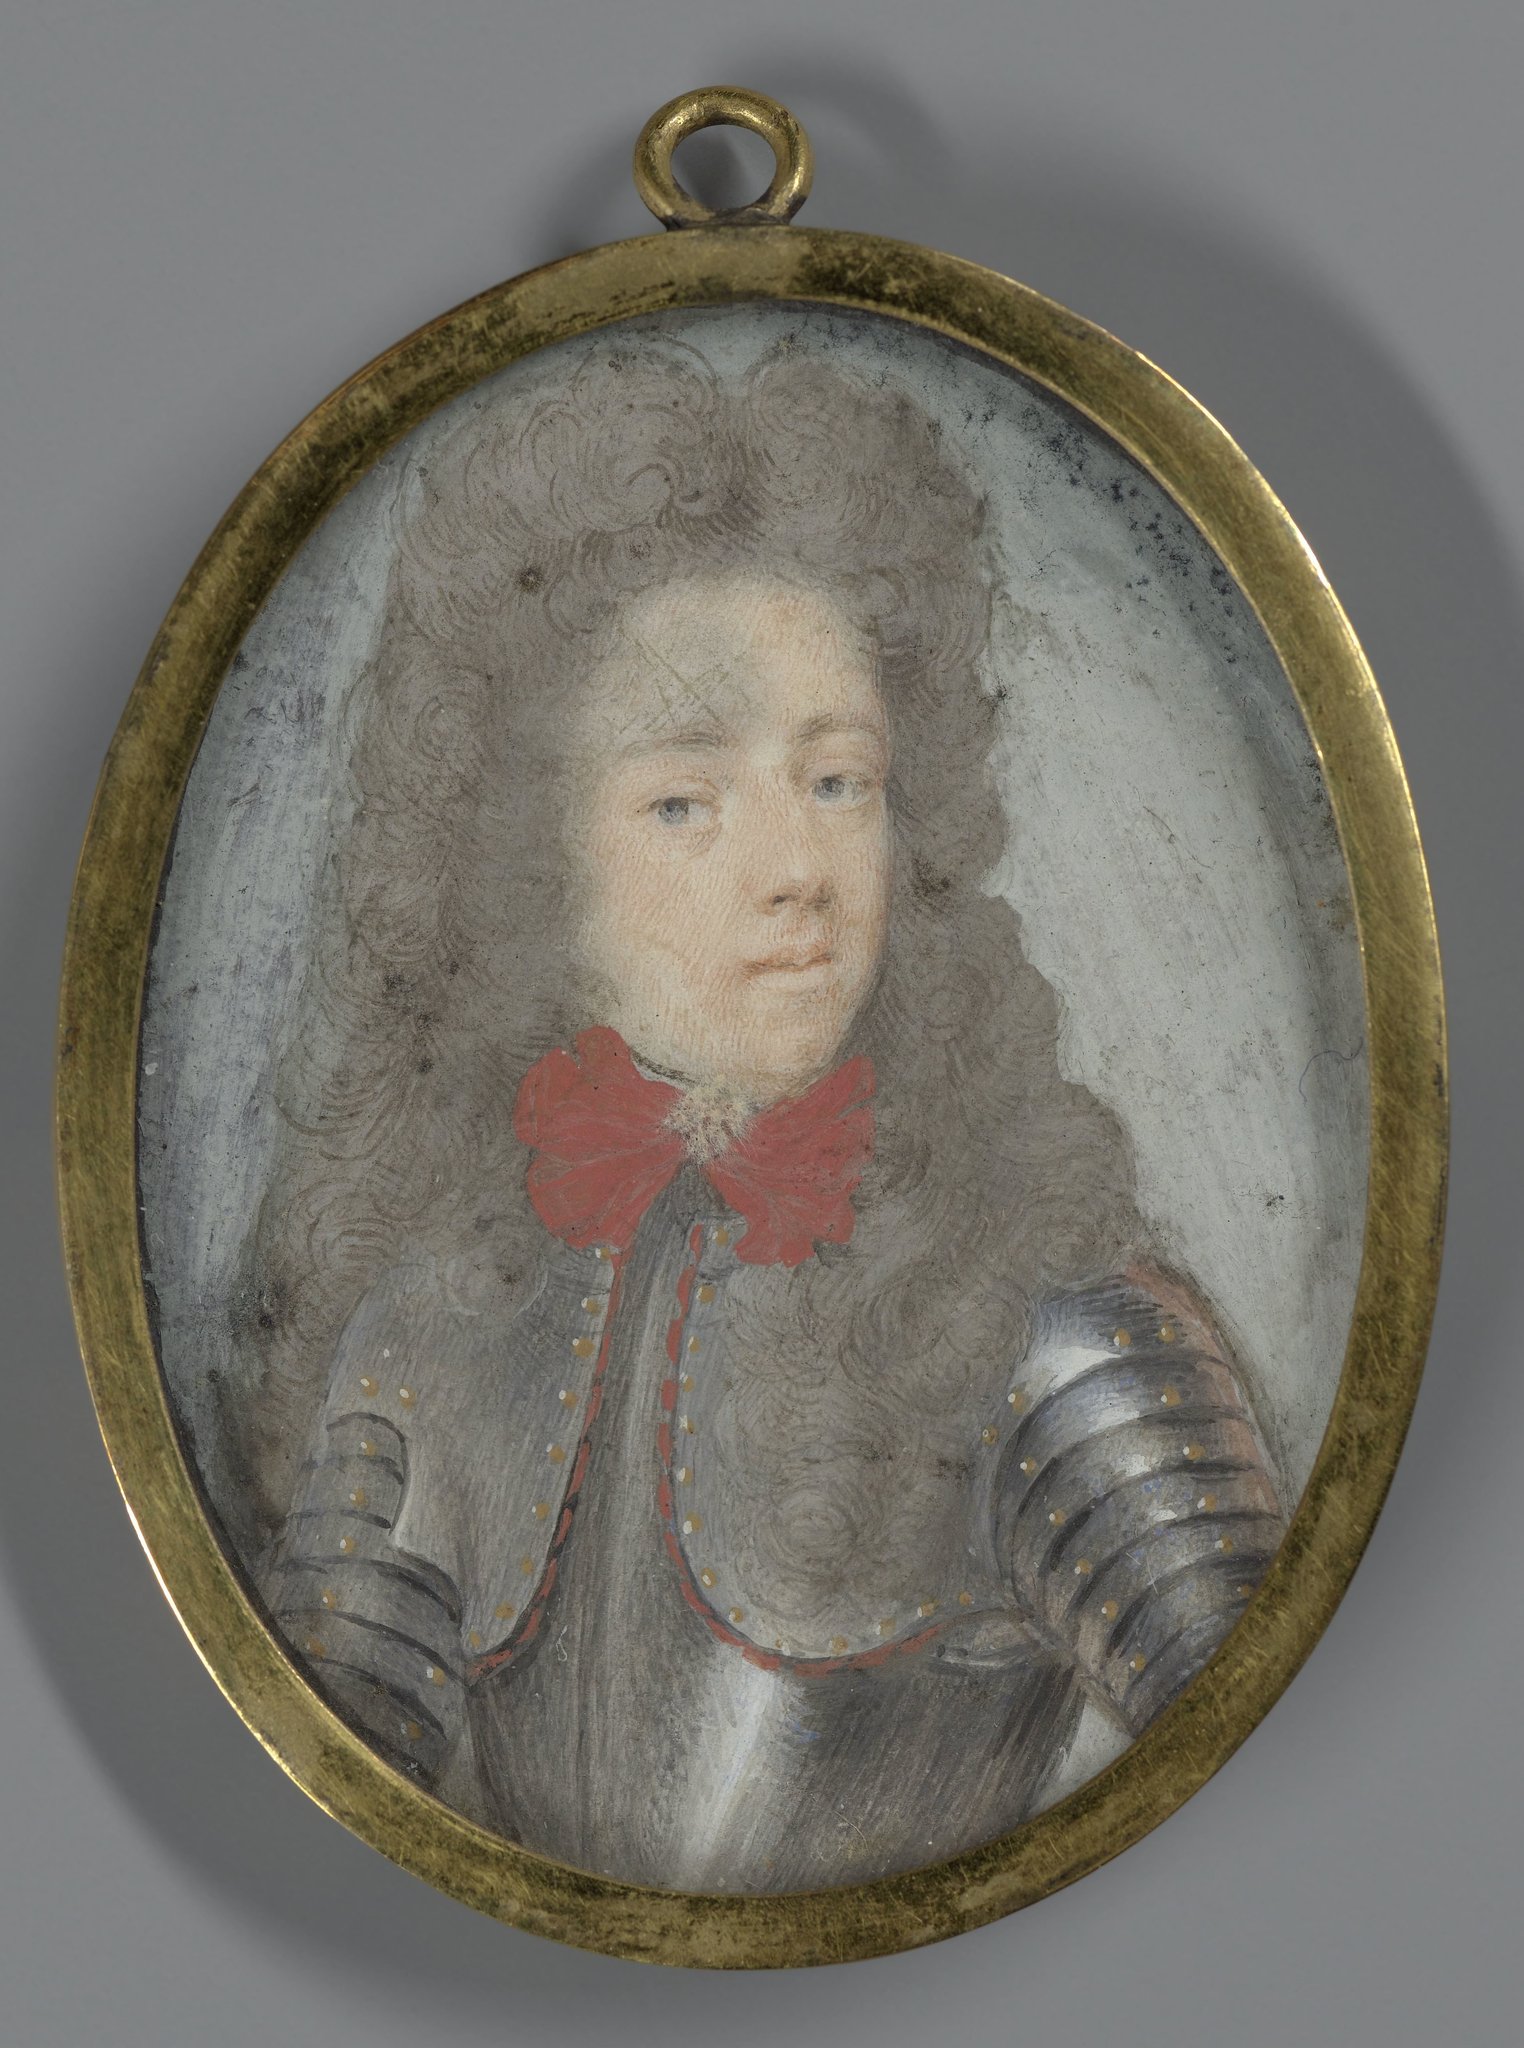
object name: painting, miniature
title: Portrait of Hendrik Casimir II (1657-96), Prince of Nassau-Dietz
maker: marie duchatel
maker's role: miniatuurschilder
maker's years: 1652-1697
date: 1690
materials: cardboard, silver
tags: hendrik casimir ii graaf van nassau-dietz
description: Portrait case with the monogram of Hendrik Casimir II, Prince of Nassau-Dietz (1657-1695). Gold and enamel Netherlands, c. 1690.